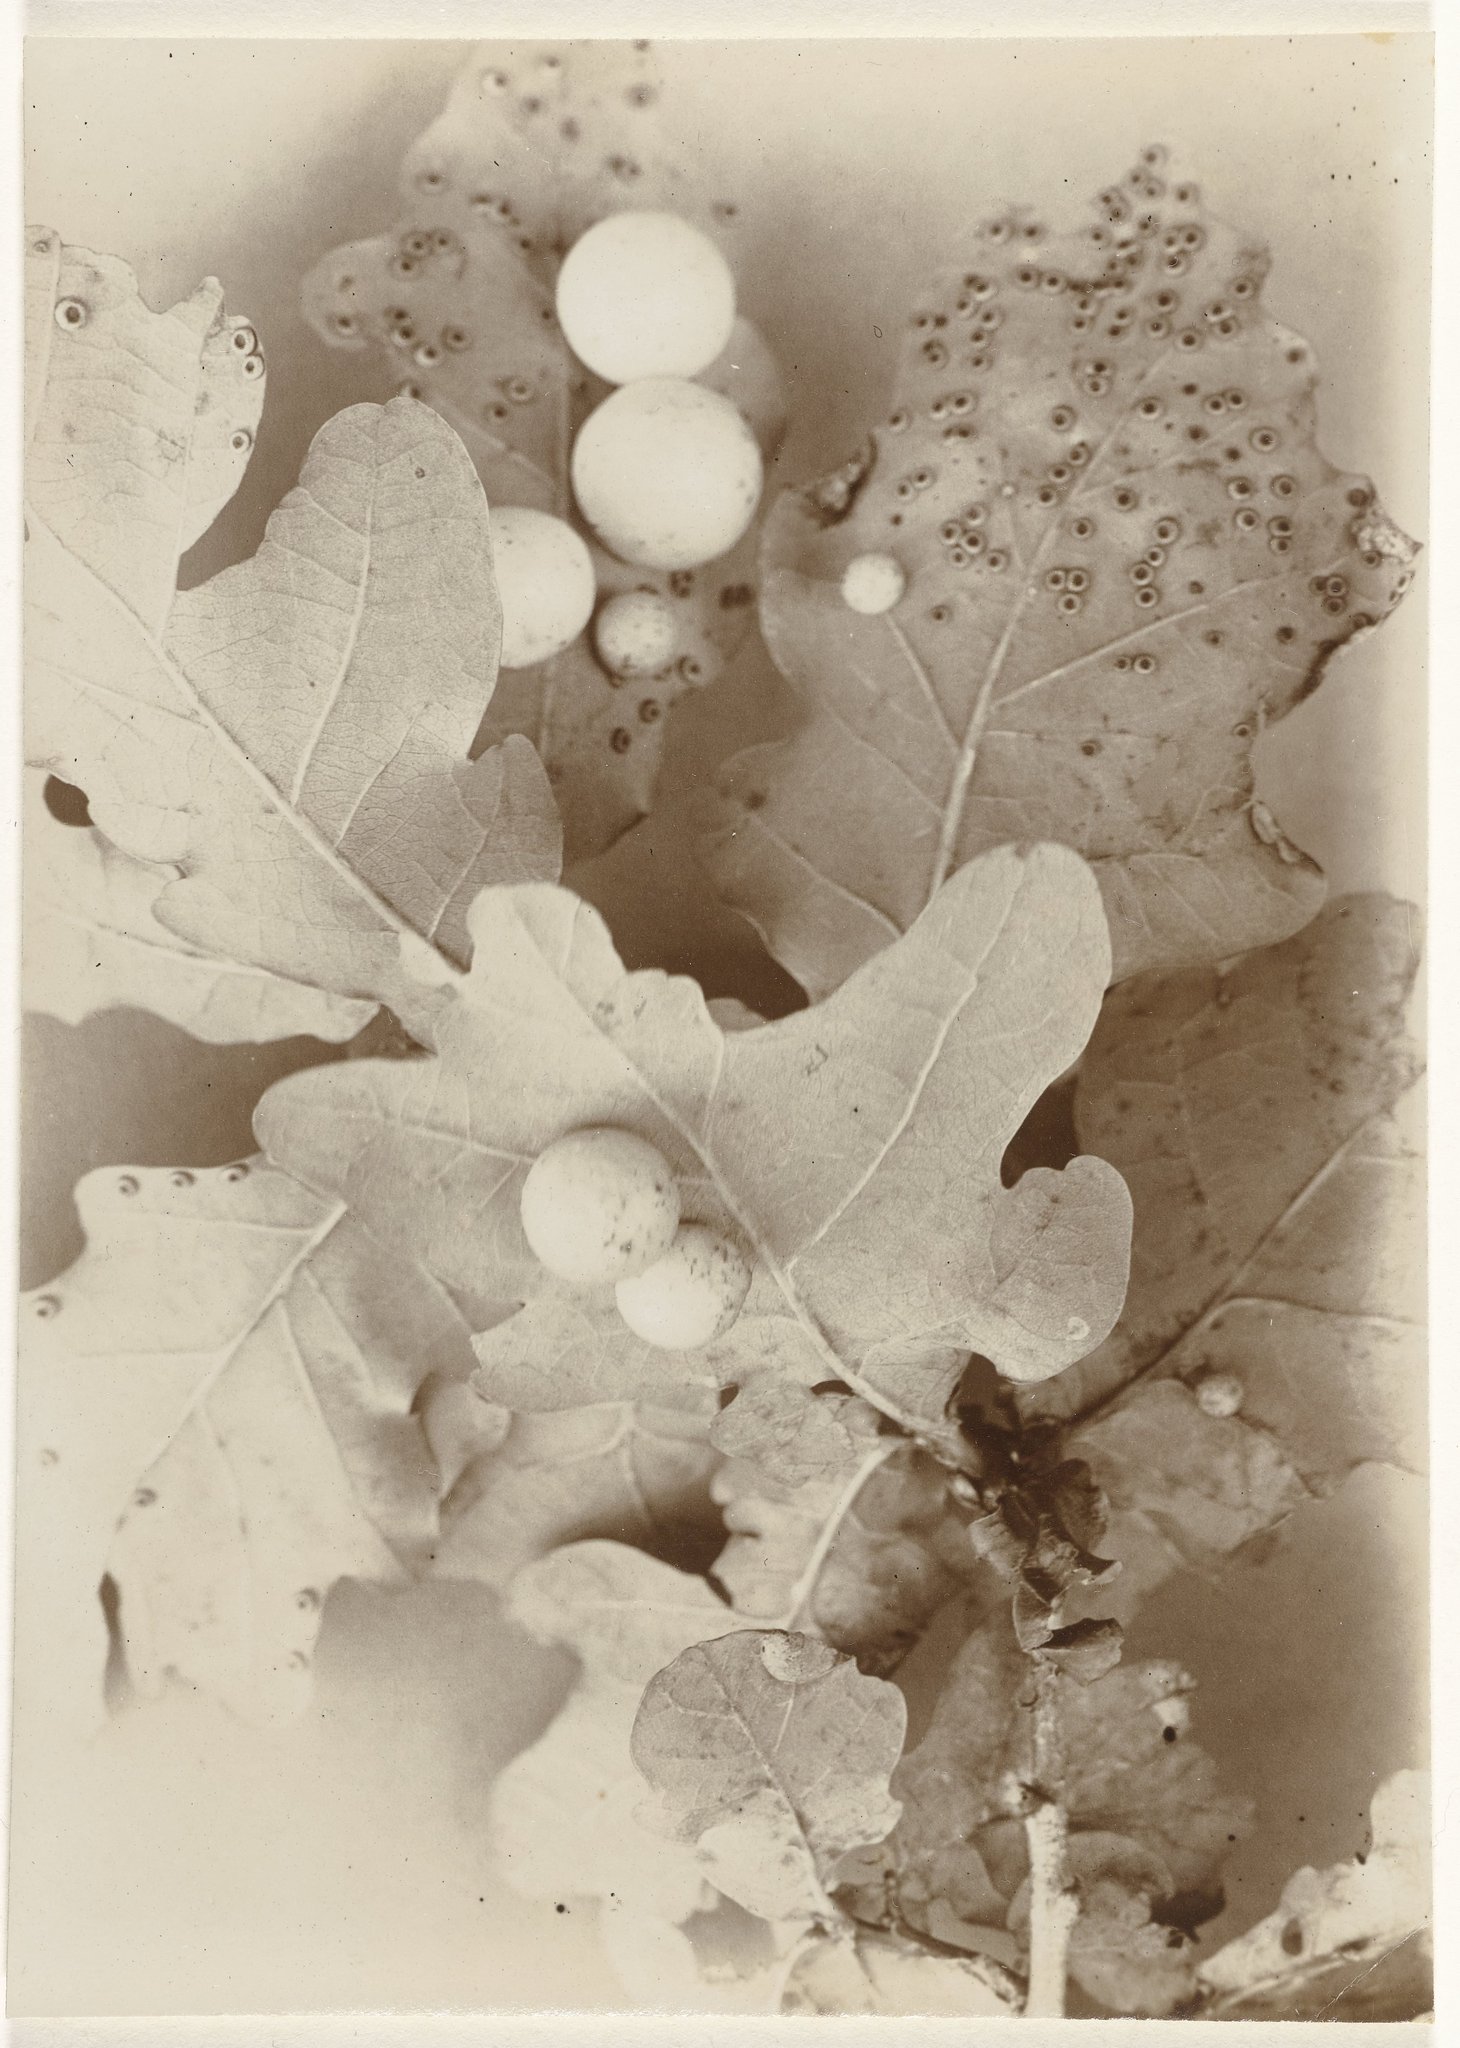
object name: photograph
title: Tak van een eik (bomen)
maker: richard tepe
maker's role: fotograaf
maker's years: 1864-1952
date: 1900-1930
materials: paper, photographic support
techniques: gelatin silver print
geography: netherlands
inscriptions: annotation: ‘bovenzyde / Eikentak met gallea’, signature: ‘foto / R Tepe’